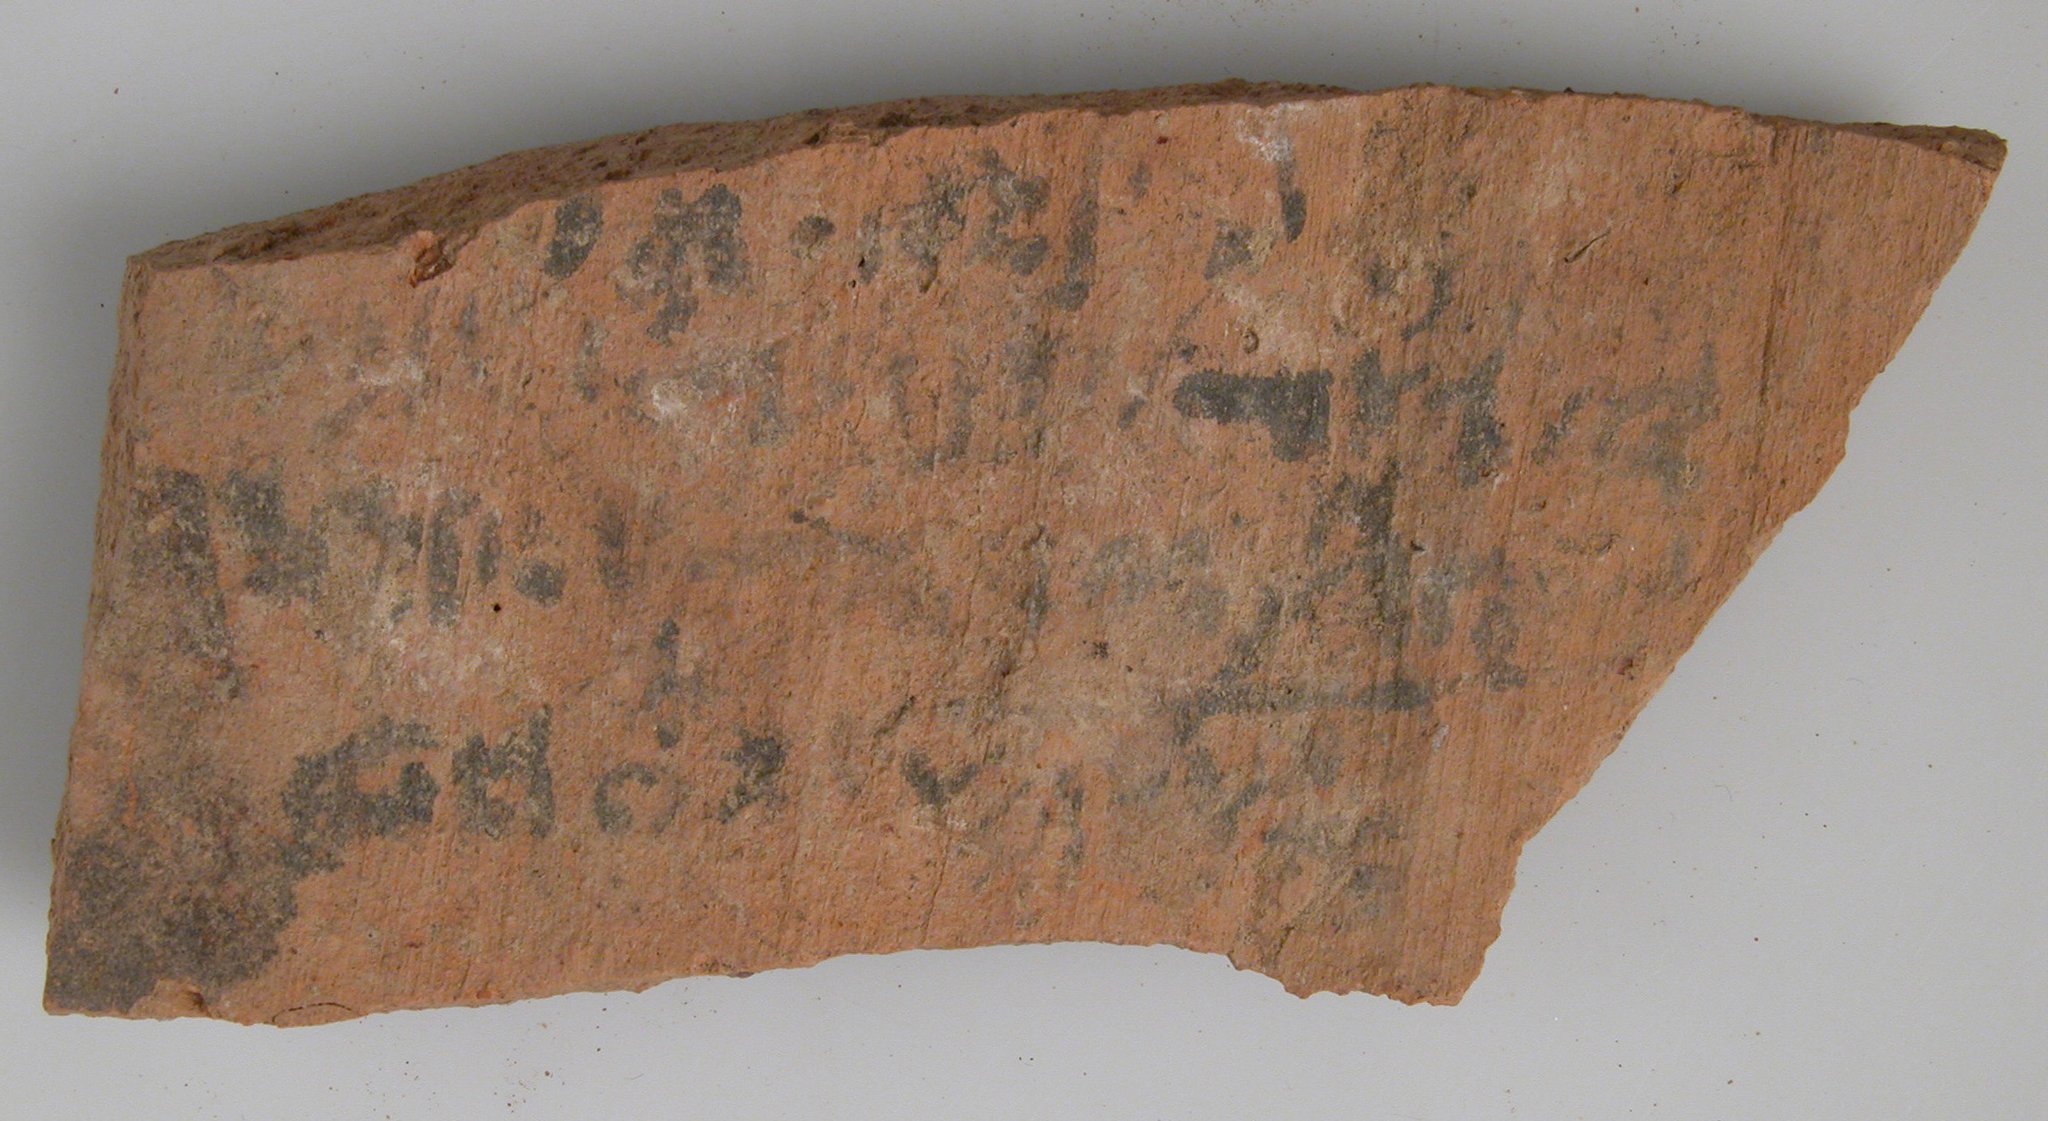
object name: ostracon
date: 400-30 BCE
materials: ink, pottery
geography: egypt